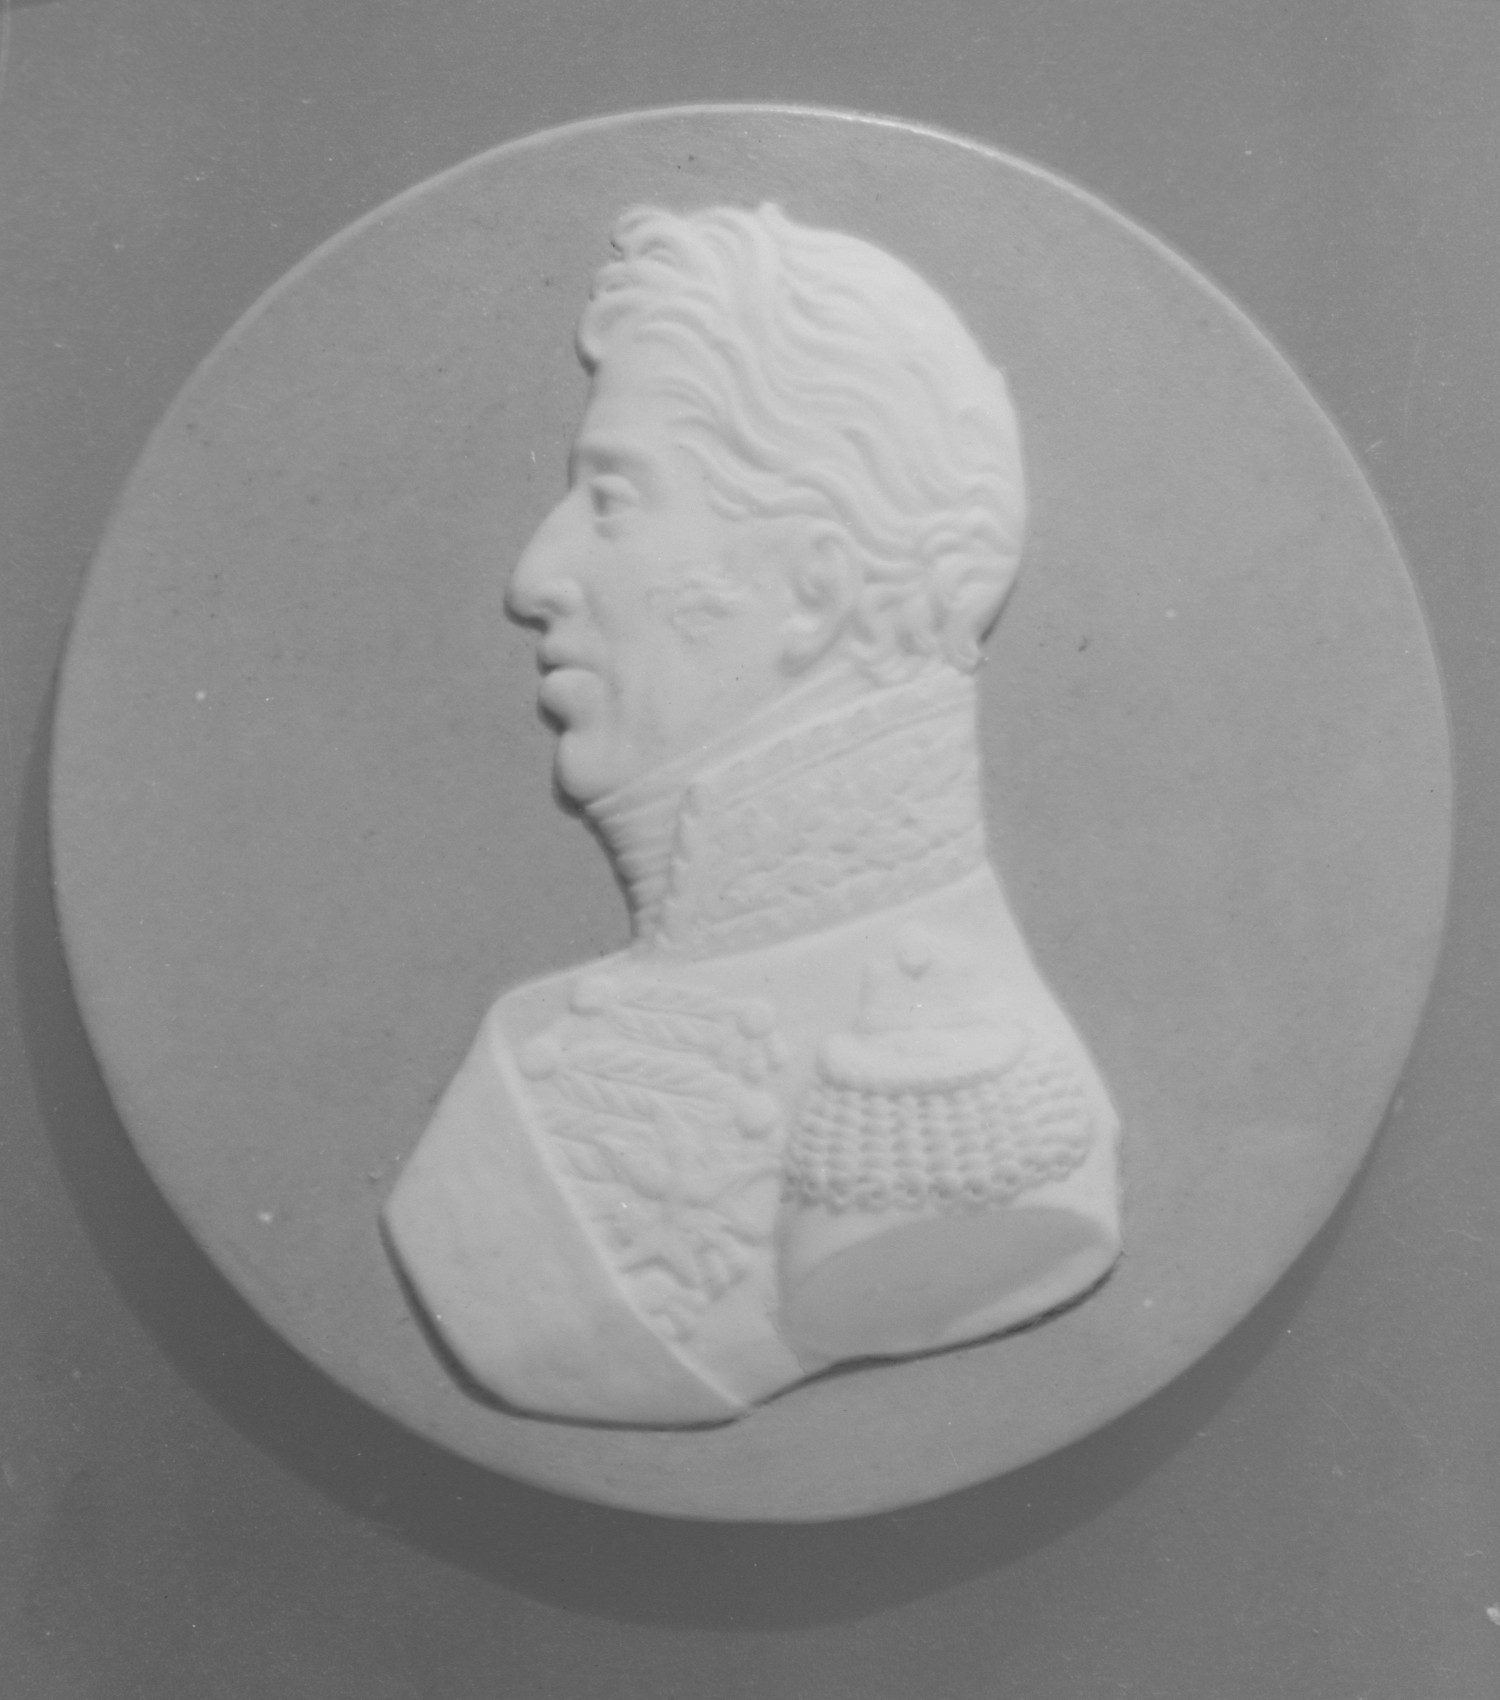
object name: medallion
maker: jean mascret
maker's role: maker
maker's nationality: french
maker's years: 1810-1848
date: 1824-1830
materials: stoneware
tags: men,profiles